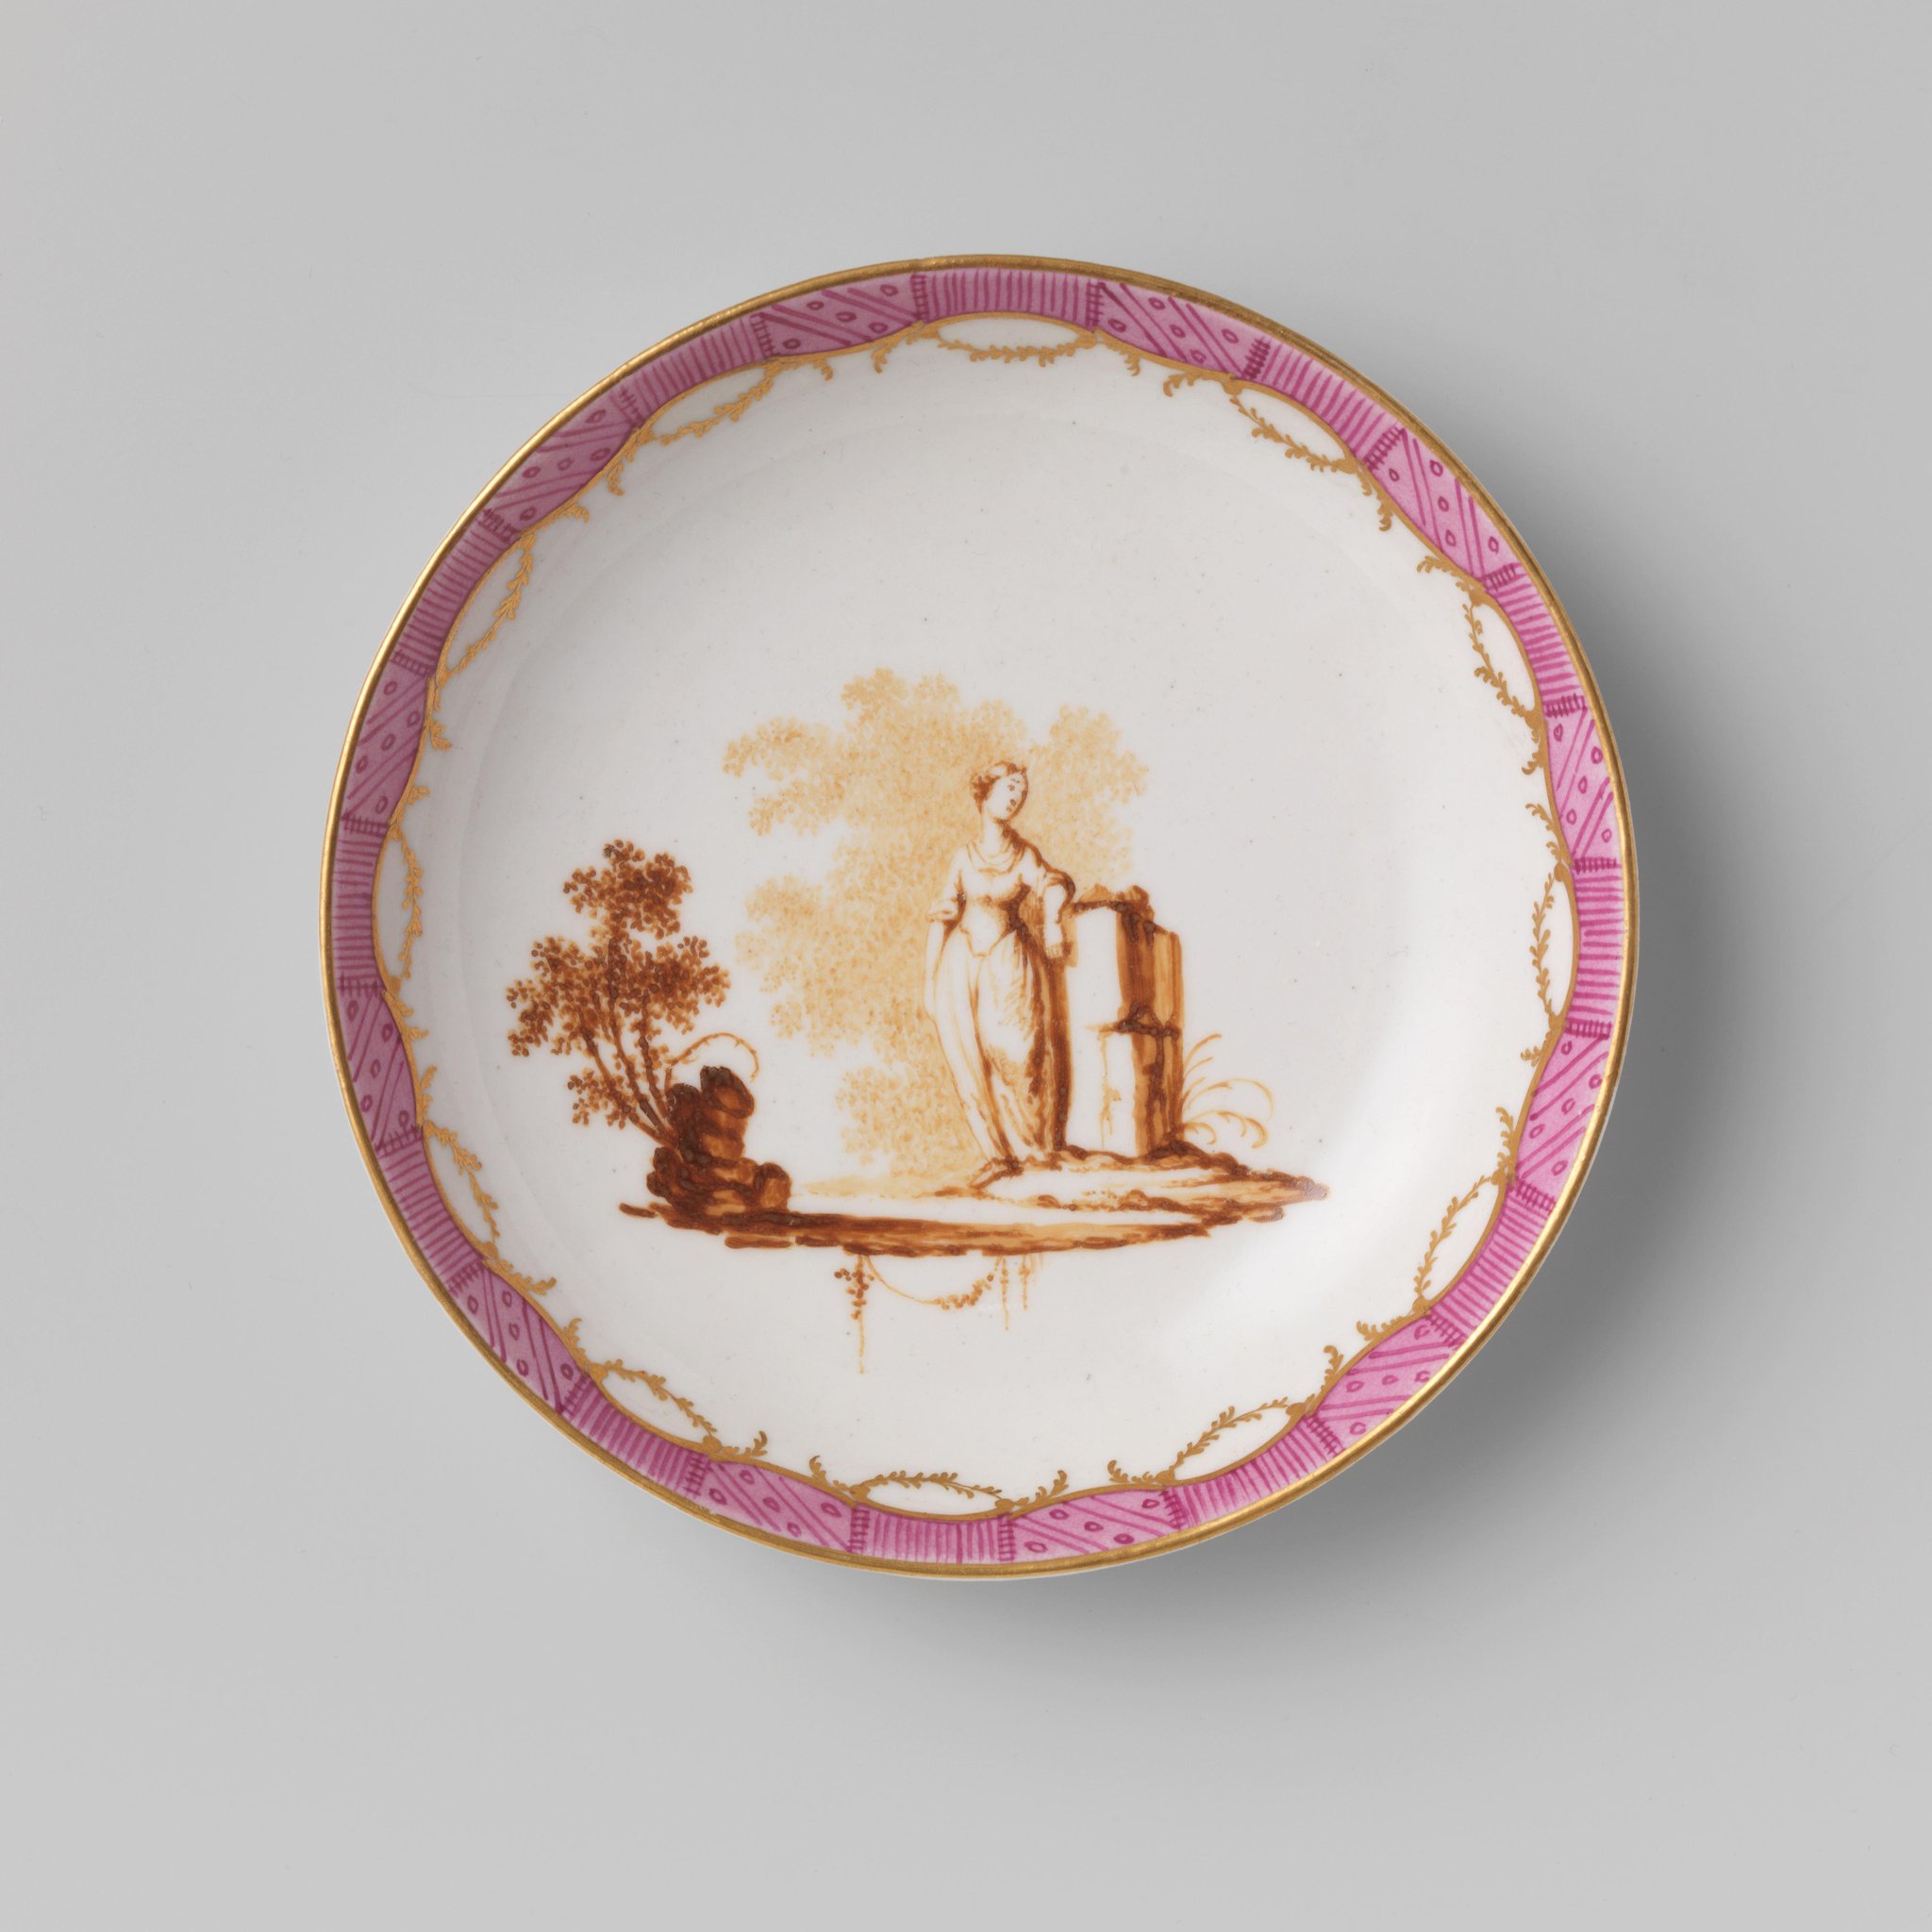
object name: platter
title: Schotel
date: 1774-1778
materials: porcelain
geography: loosdrecht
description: Schotel van porselein. Beschilderd in sepia met figuren in een landschap. Langs de rand een lila fries tussen gouden biezen.